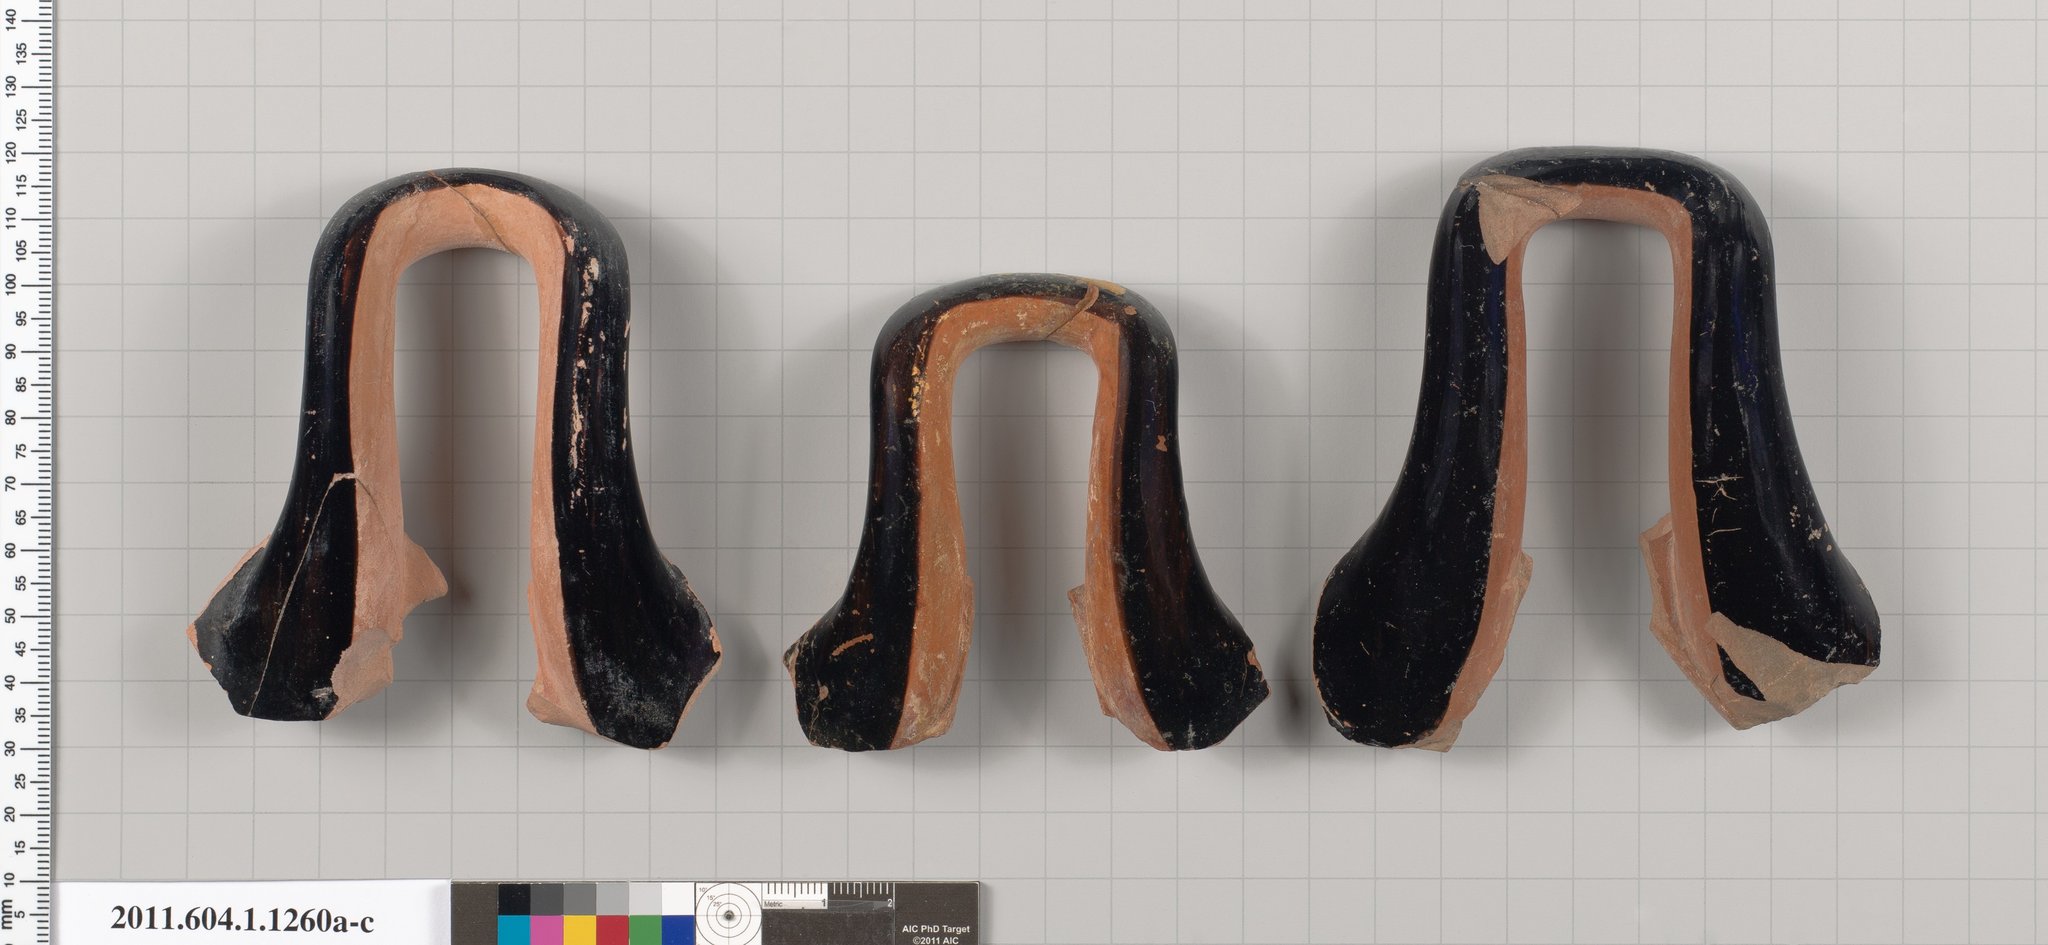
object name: kylix fragment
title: Terracotta fragments of kylikes (drinking cups)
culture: greek, attic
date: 500-401 BCE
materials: terracotta